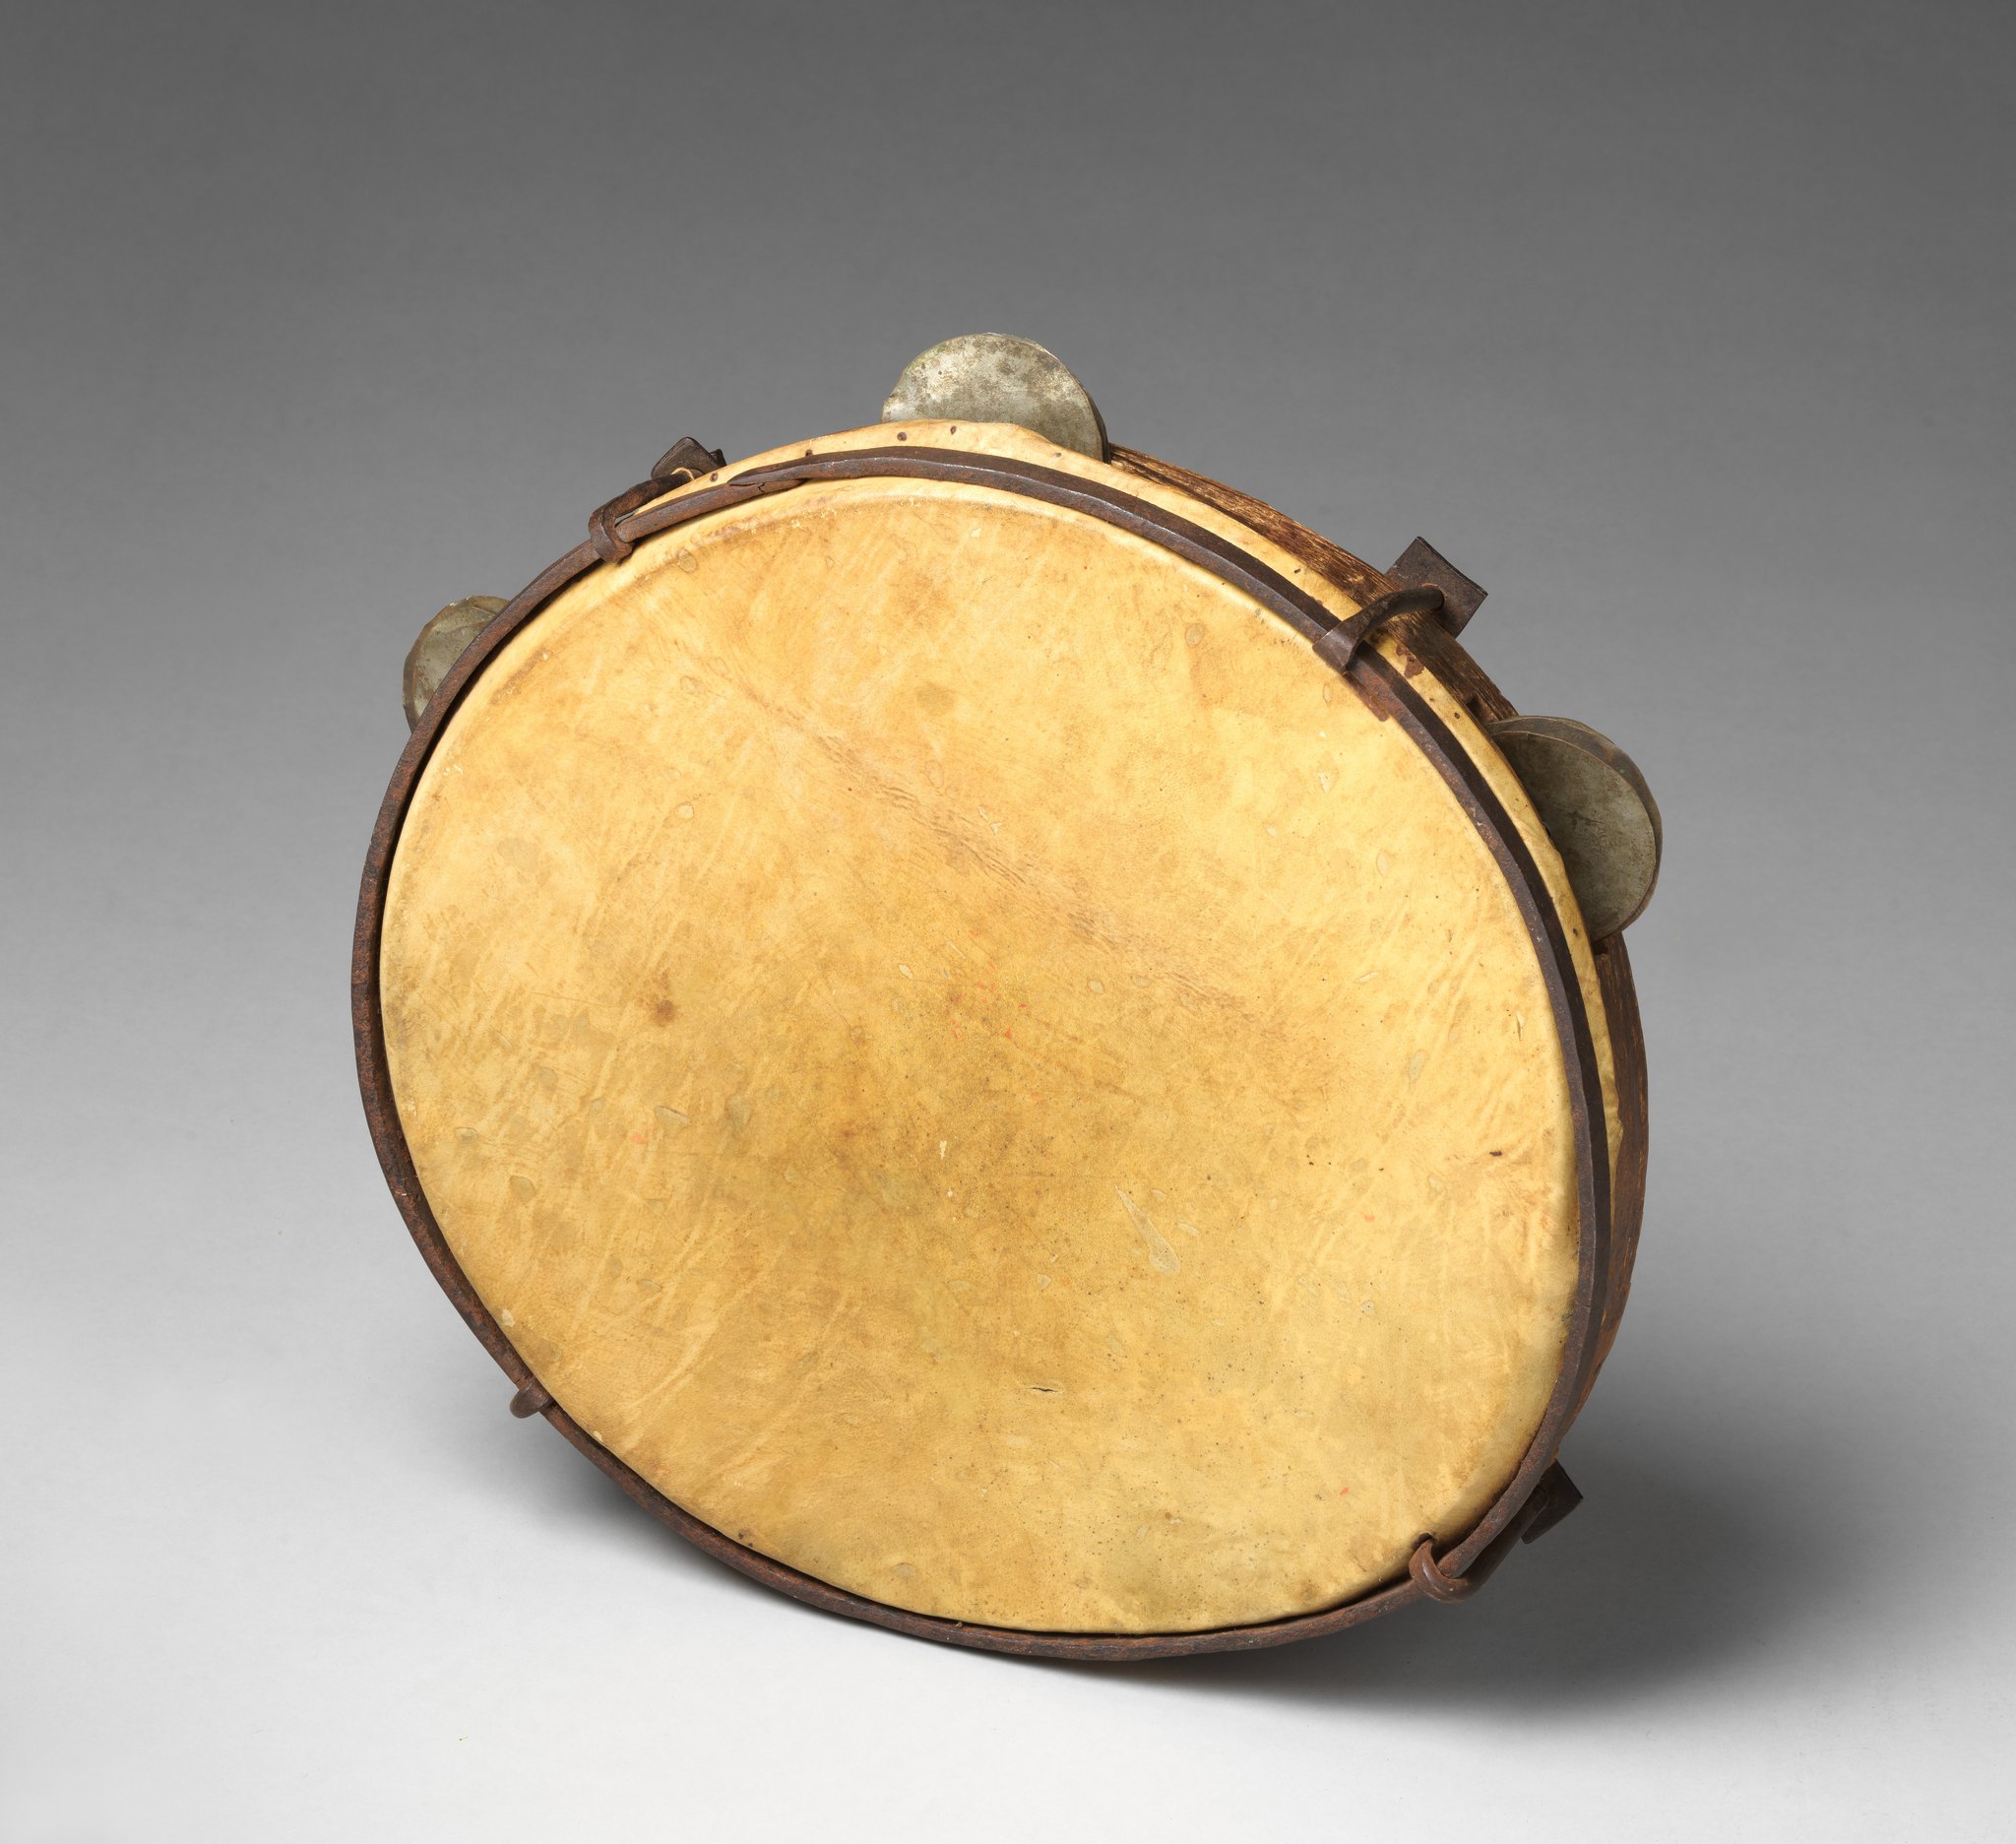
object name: tambourine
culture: american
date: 1801-1900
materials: metal, wood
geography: united states